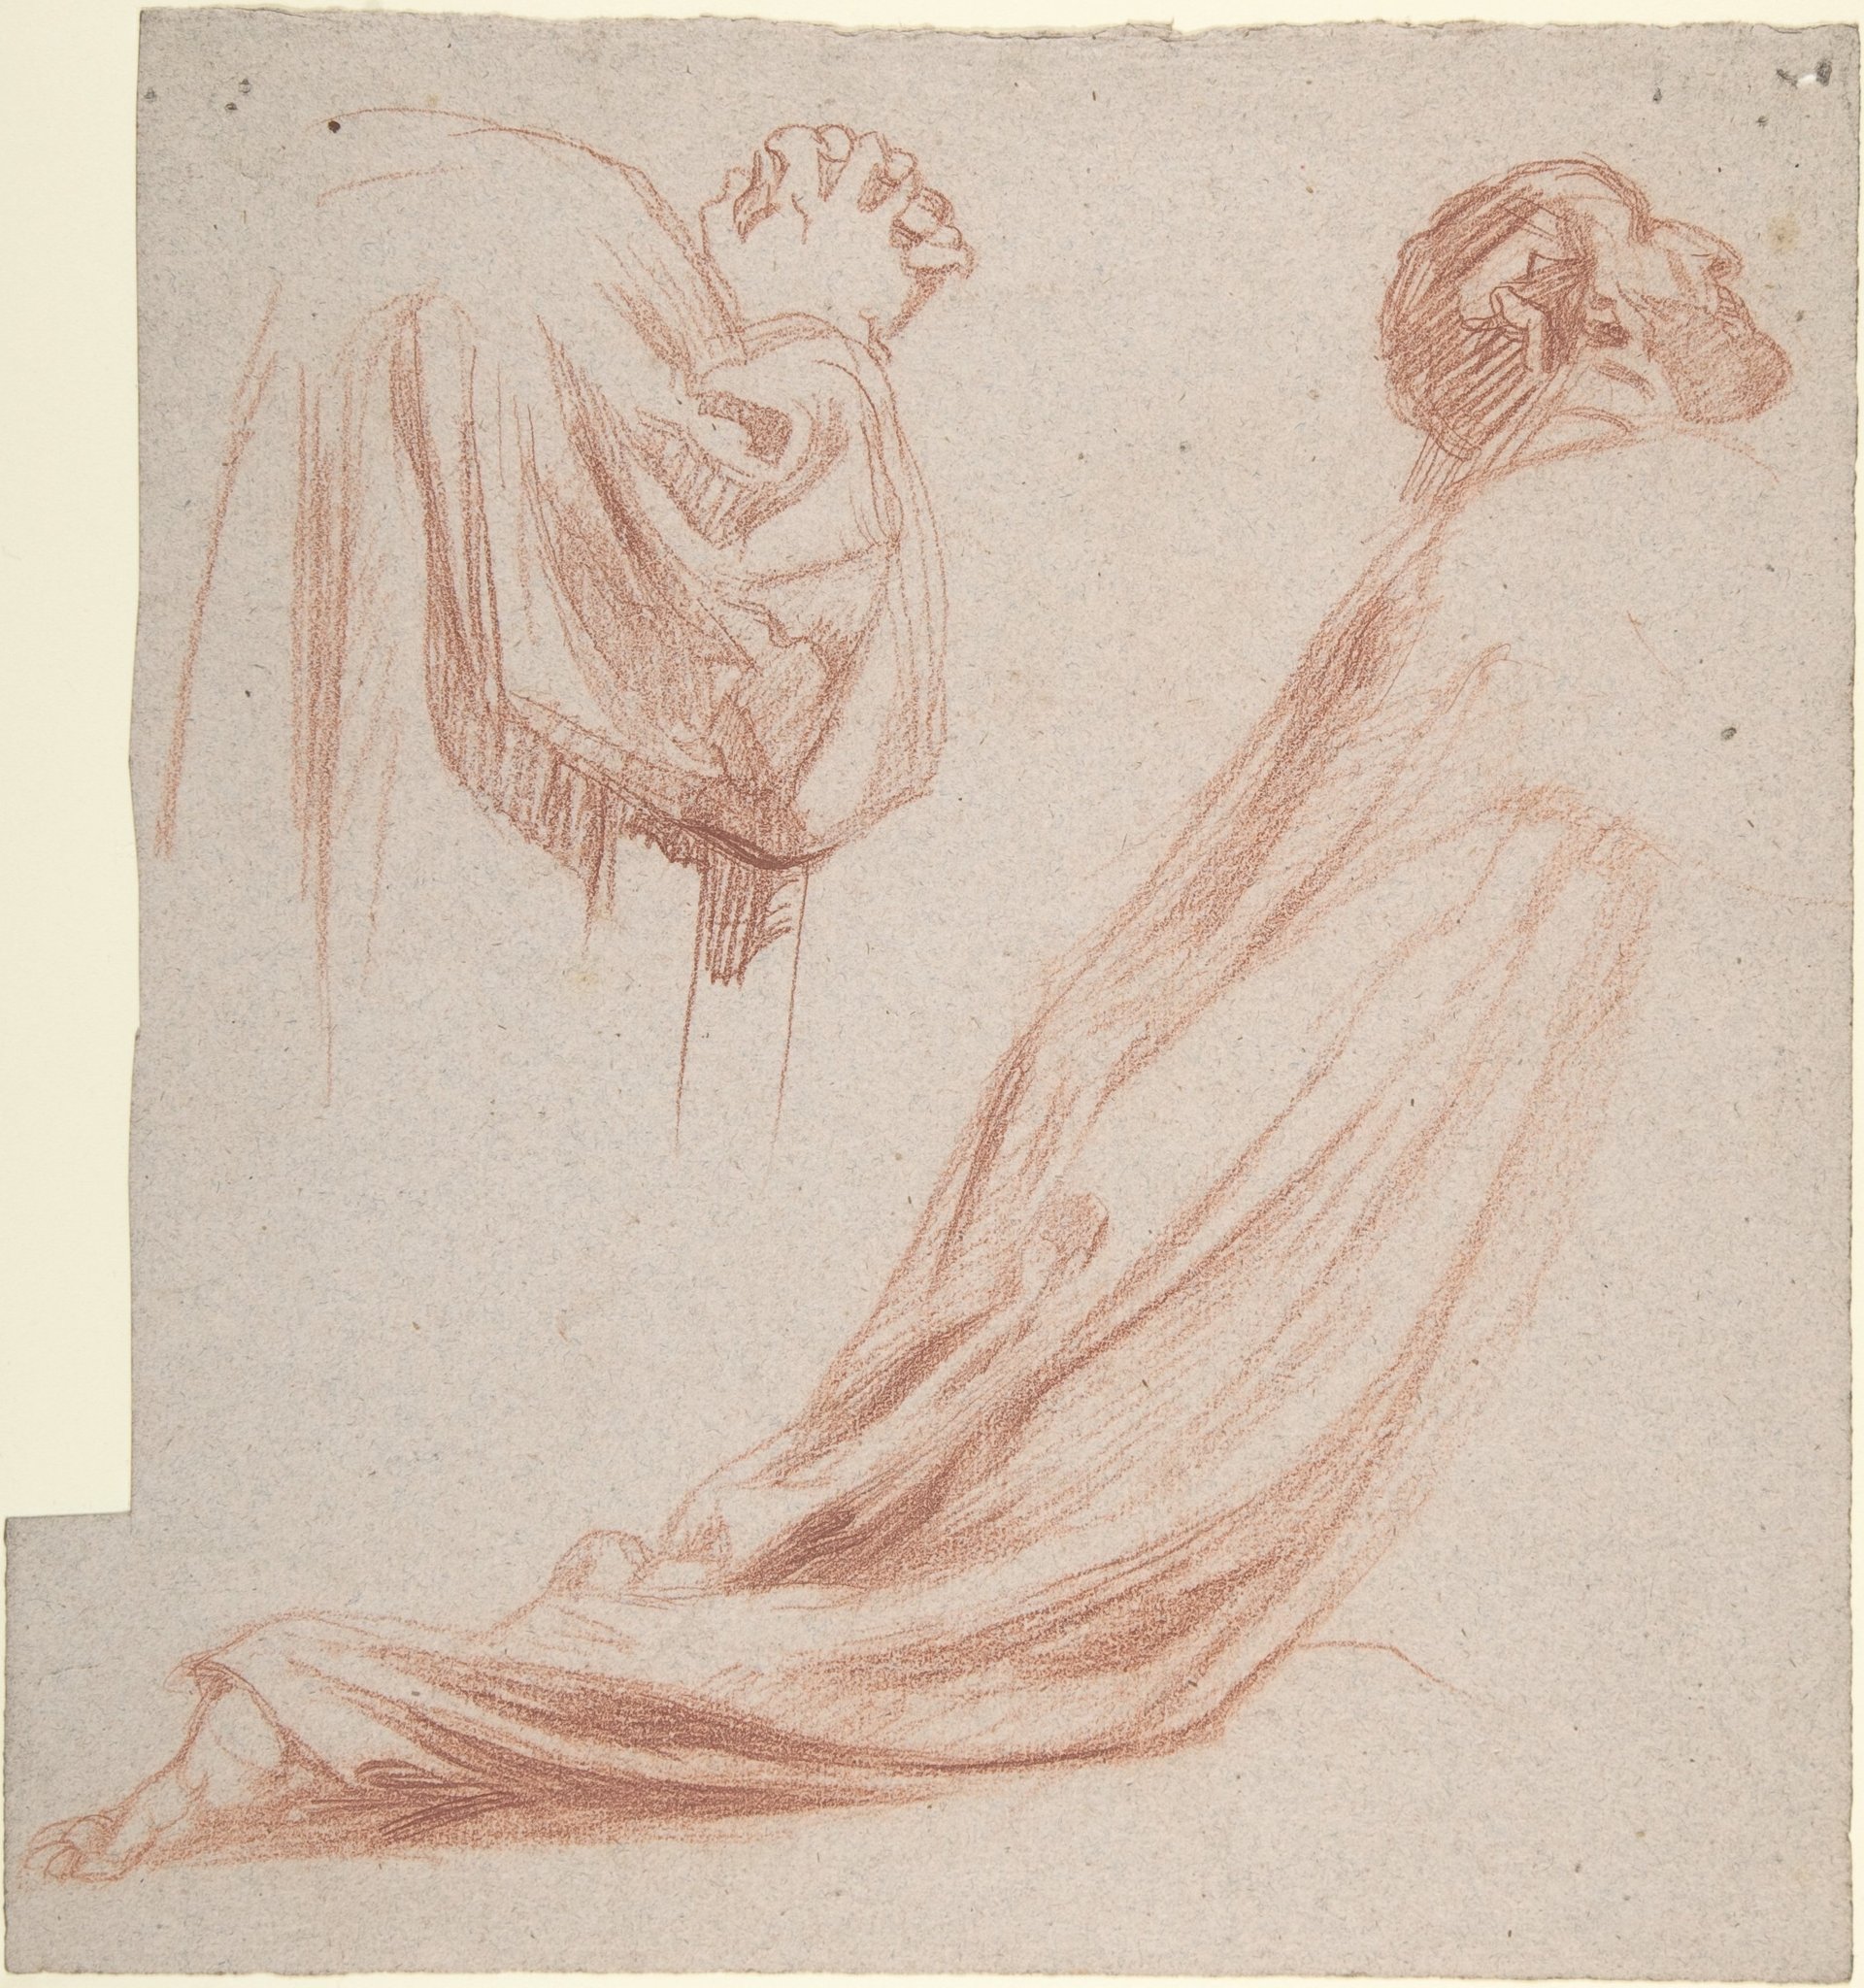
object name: drawing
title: Two Kneeling Figures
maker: alexandre laemlein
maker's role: artist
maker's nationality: french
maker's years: 1813-1871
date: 1830-1871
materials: chalk, paper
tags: men